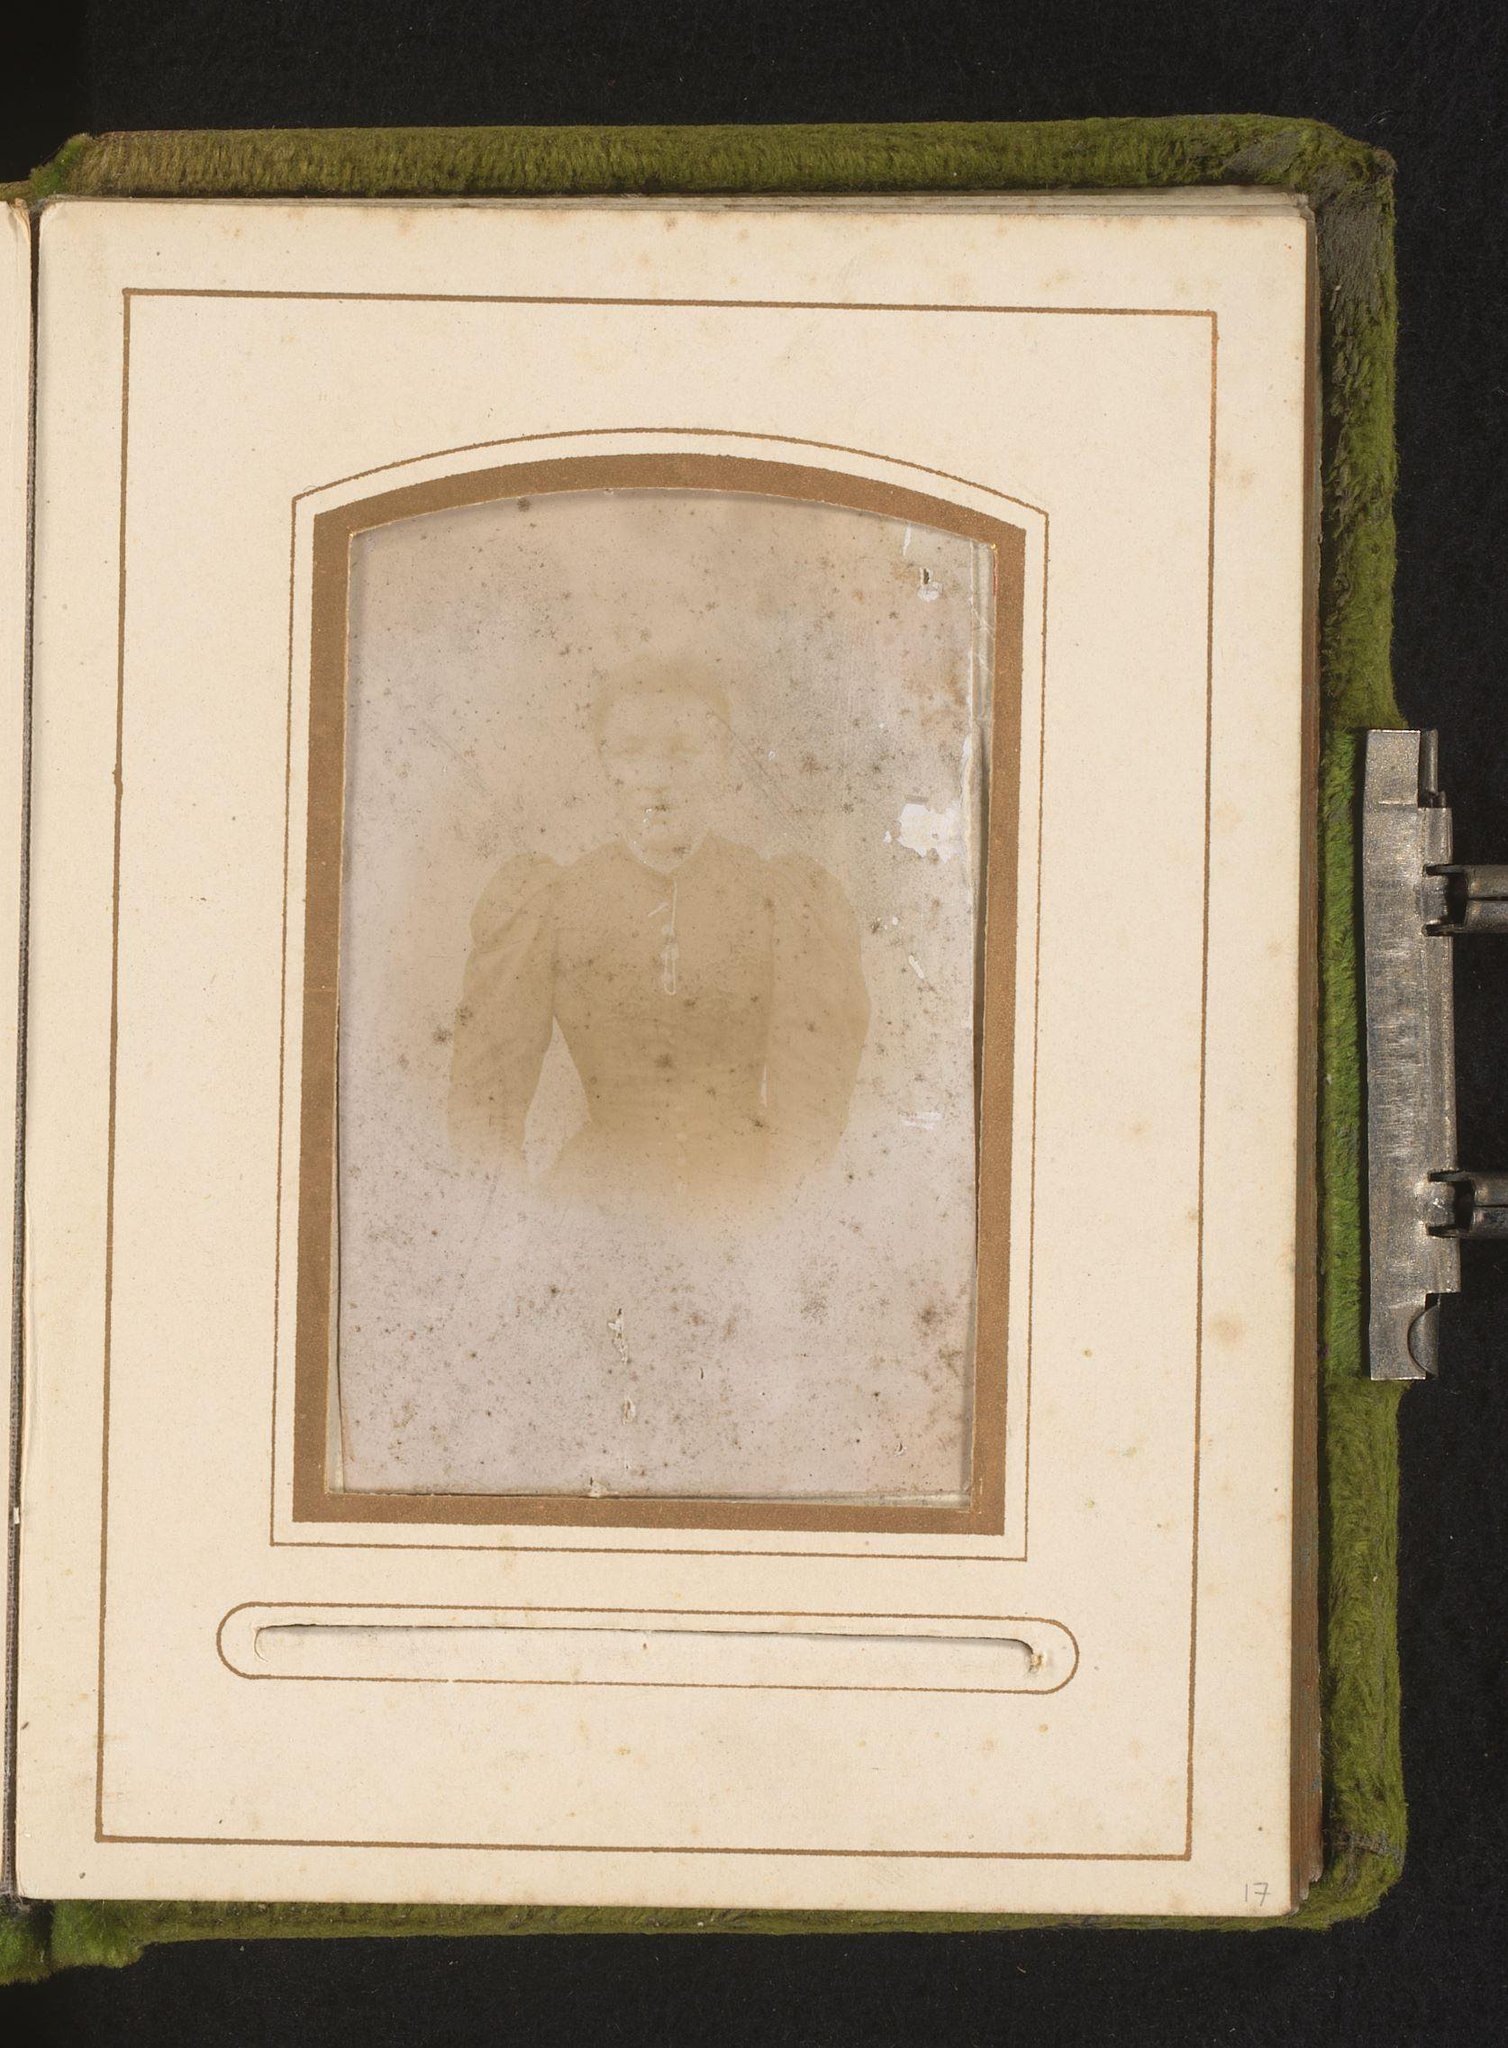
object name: album leaf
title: Portret van een vrouw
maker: Anonymous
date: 1860-1900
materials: cardboard, photographic support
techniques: daylight paper print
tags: adult woman, historical persons